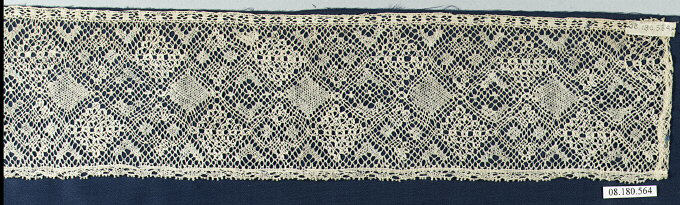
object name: piece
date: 1701-1800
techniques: lace